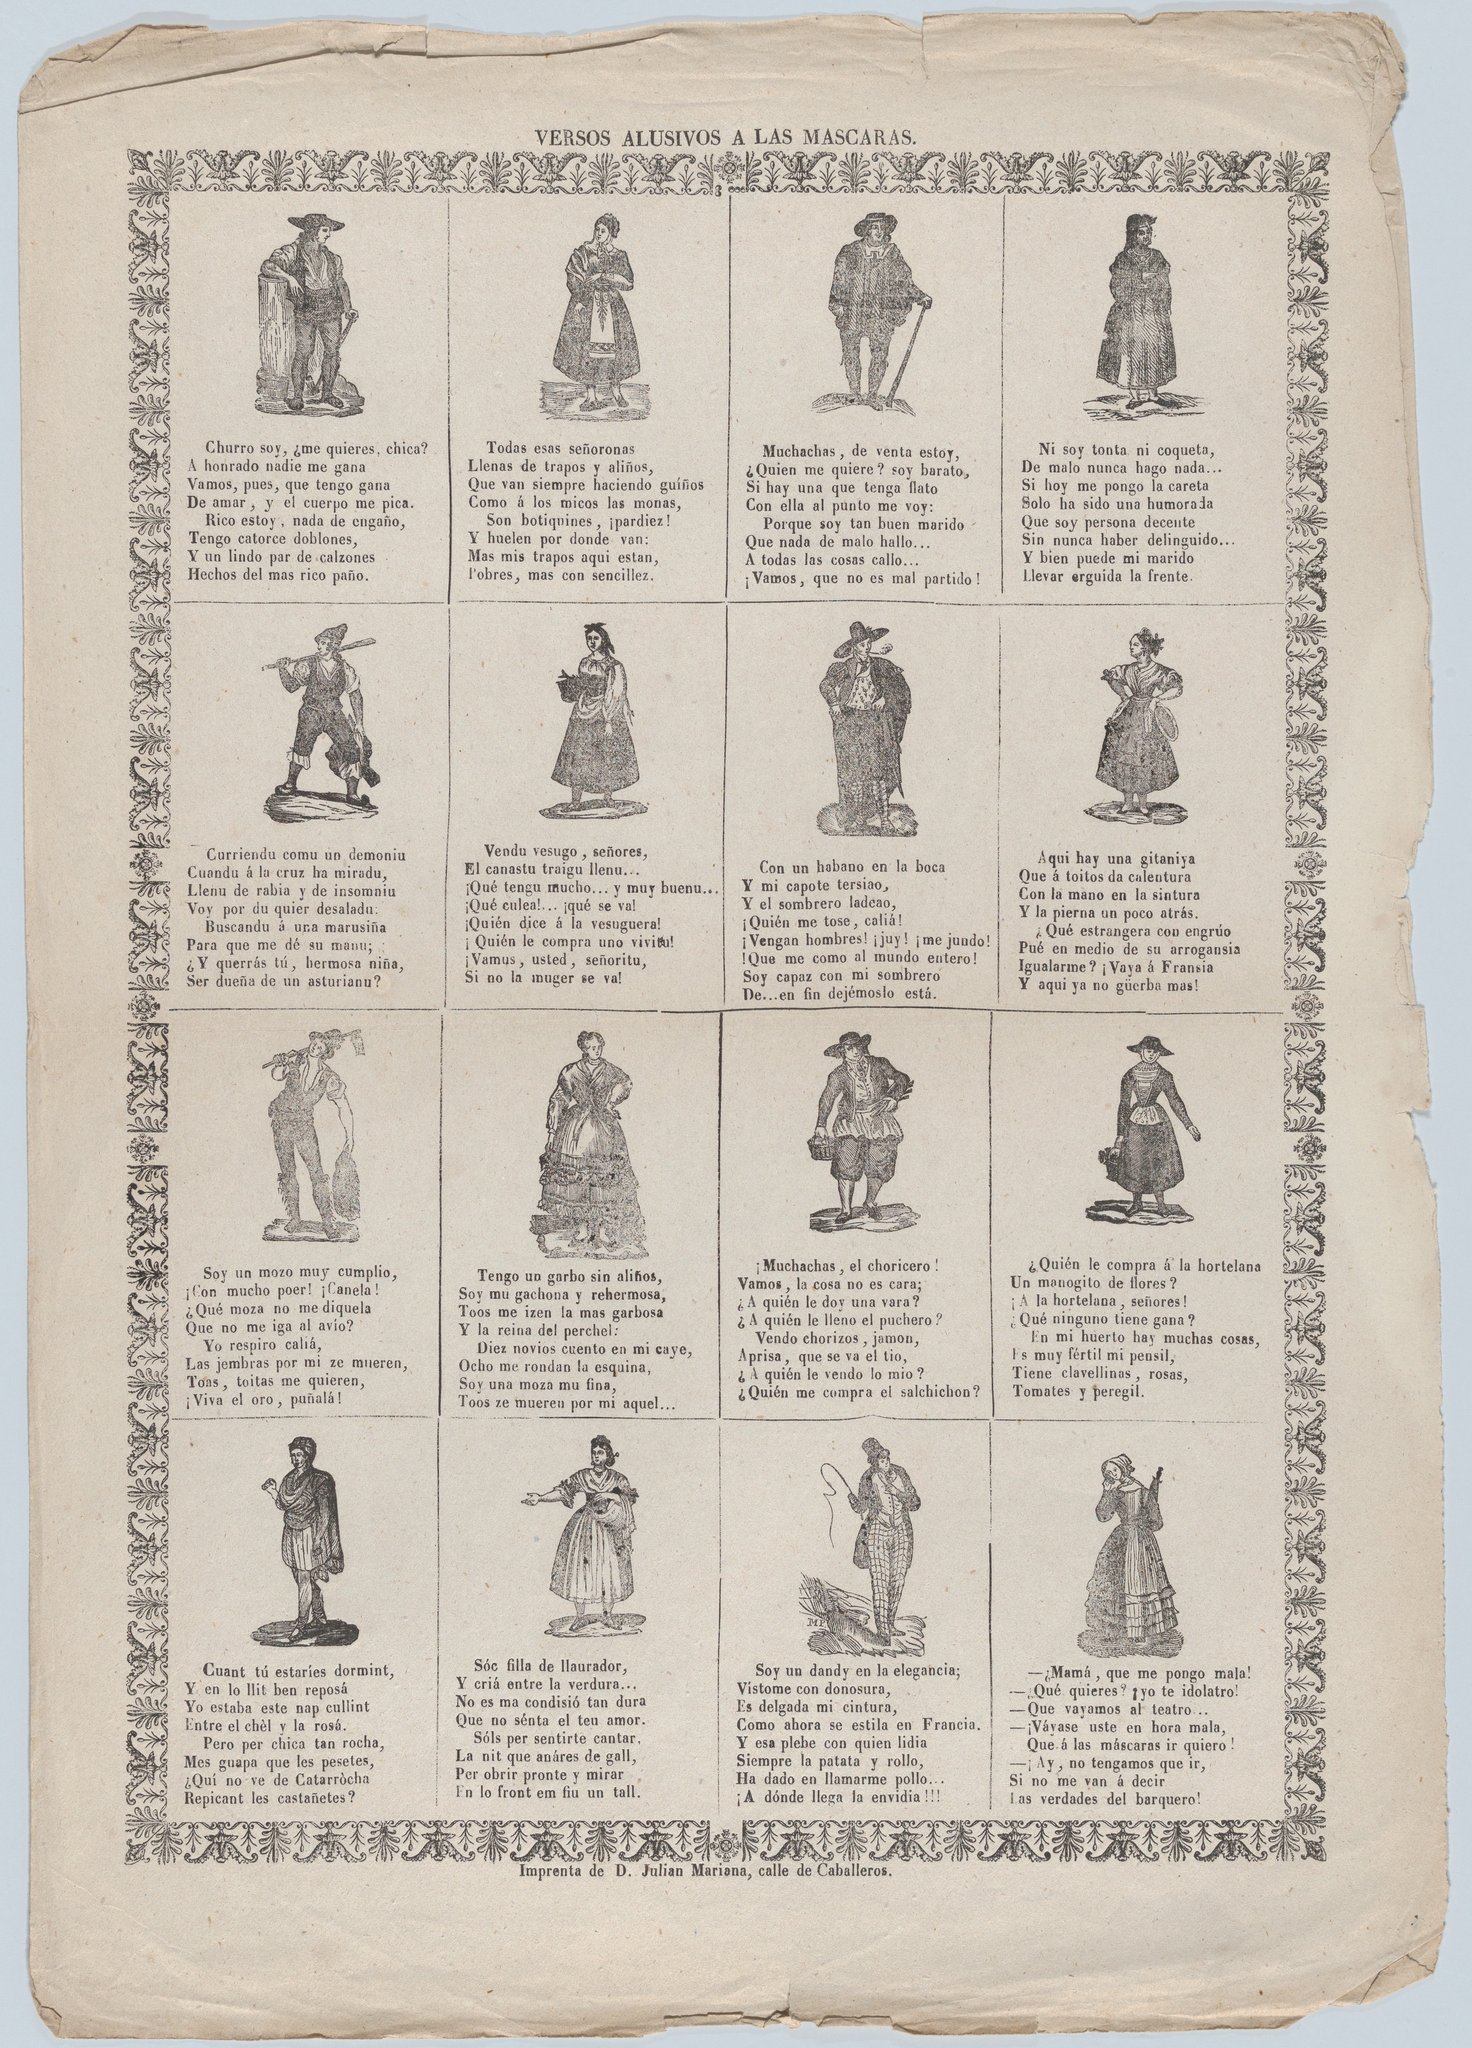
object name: print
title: Allusive verses for masquerades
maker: julian mariana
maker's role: publisher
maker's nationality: spanish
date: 1860-1870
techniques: letterpress, engraving